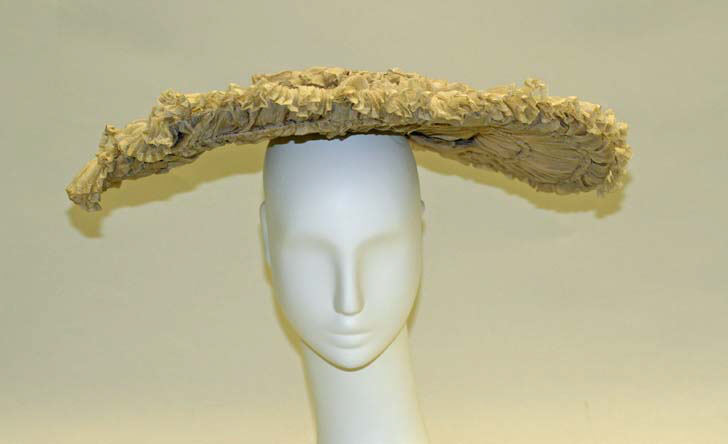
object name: hat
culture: american or european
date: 1900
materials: silk